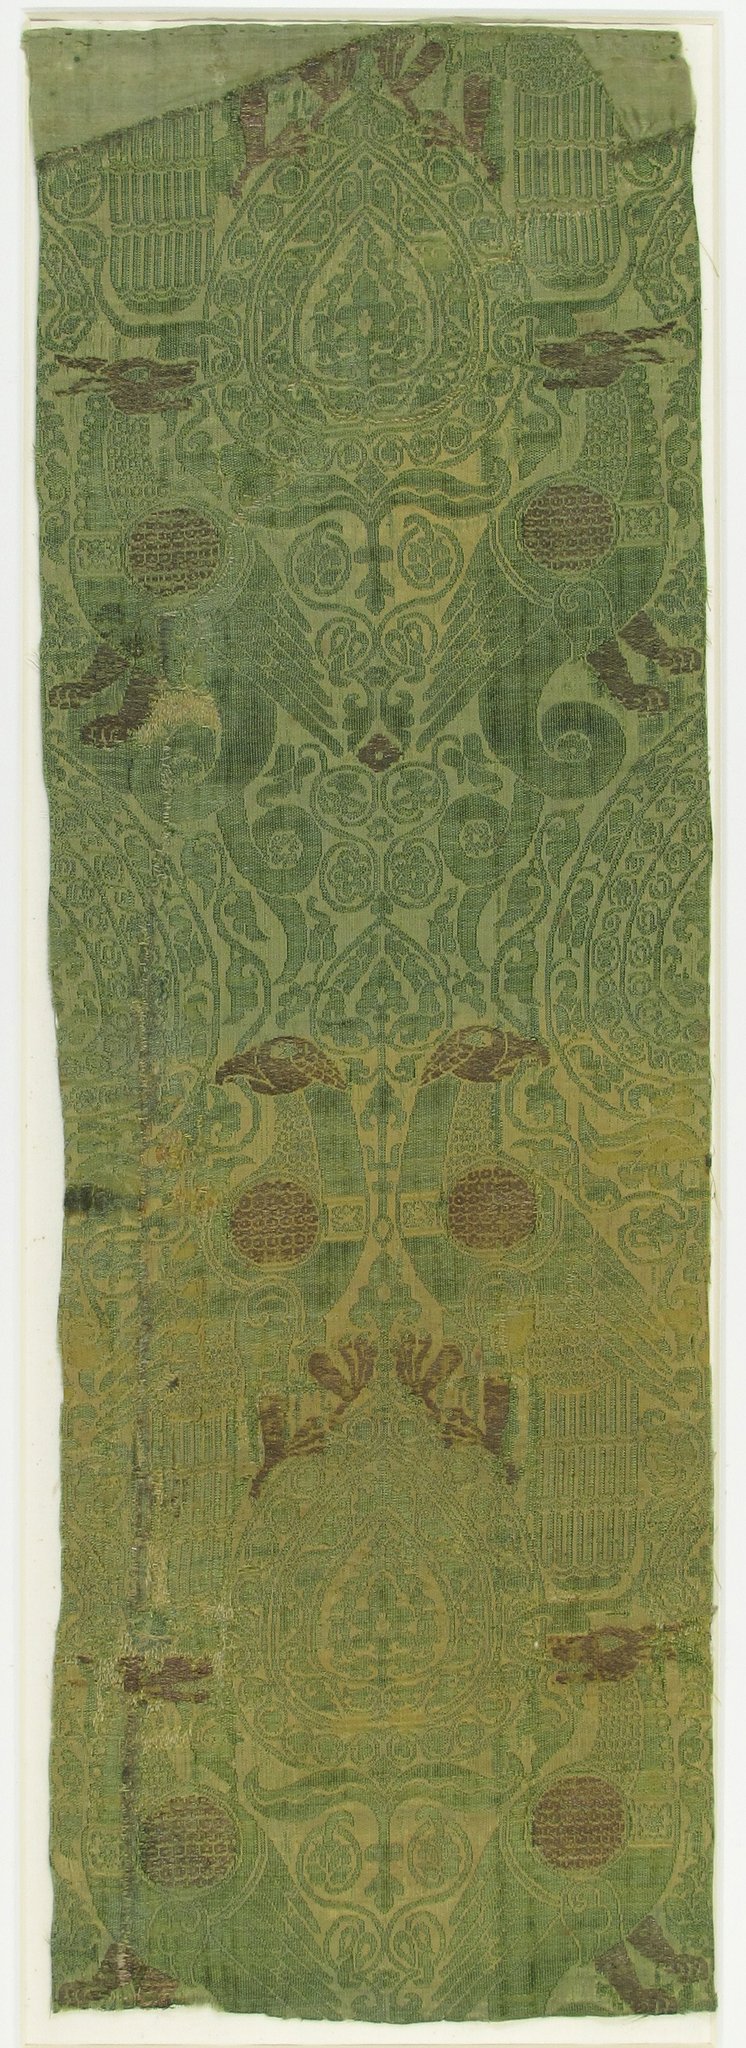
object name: textile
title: Textile with Brocade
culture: italian or spanish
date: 1201-1300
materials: metal thread, silk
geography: italy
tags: birds